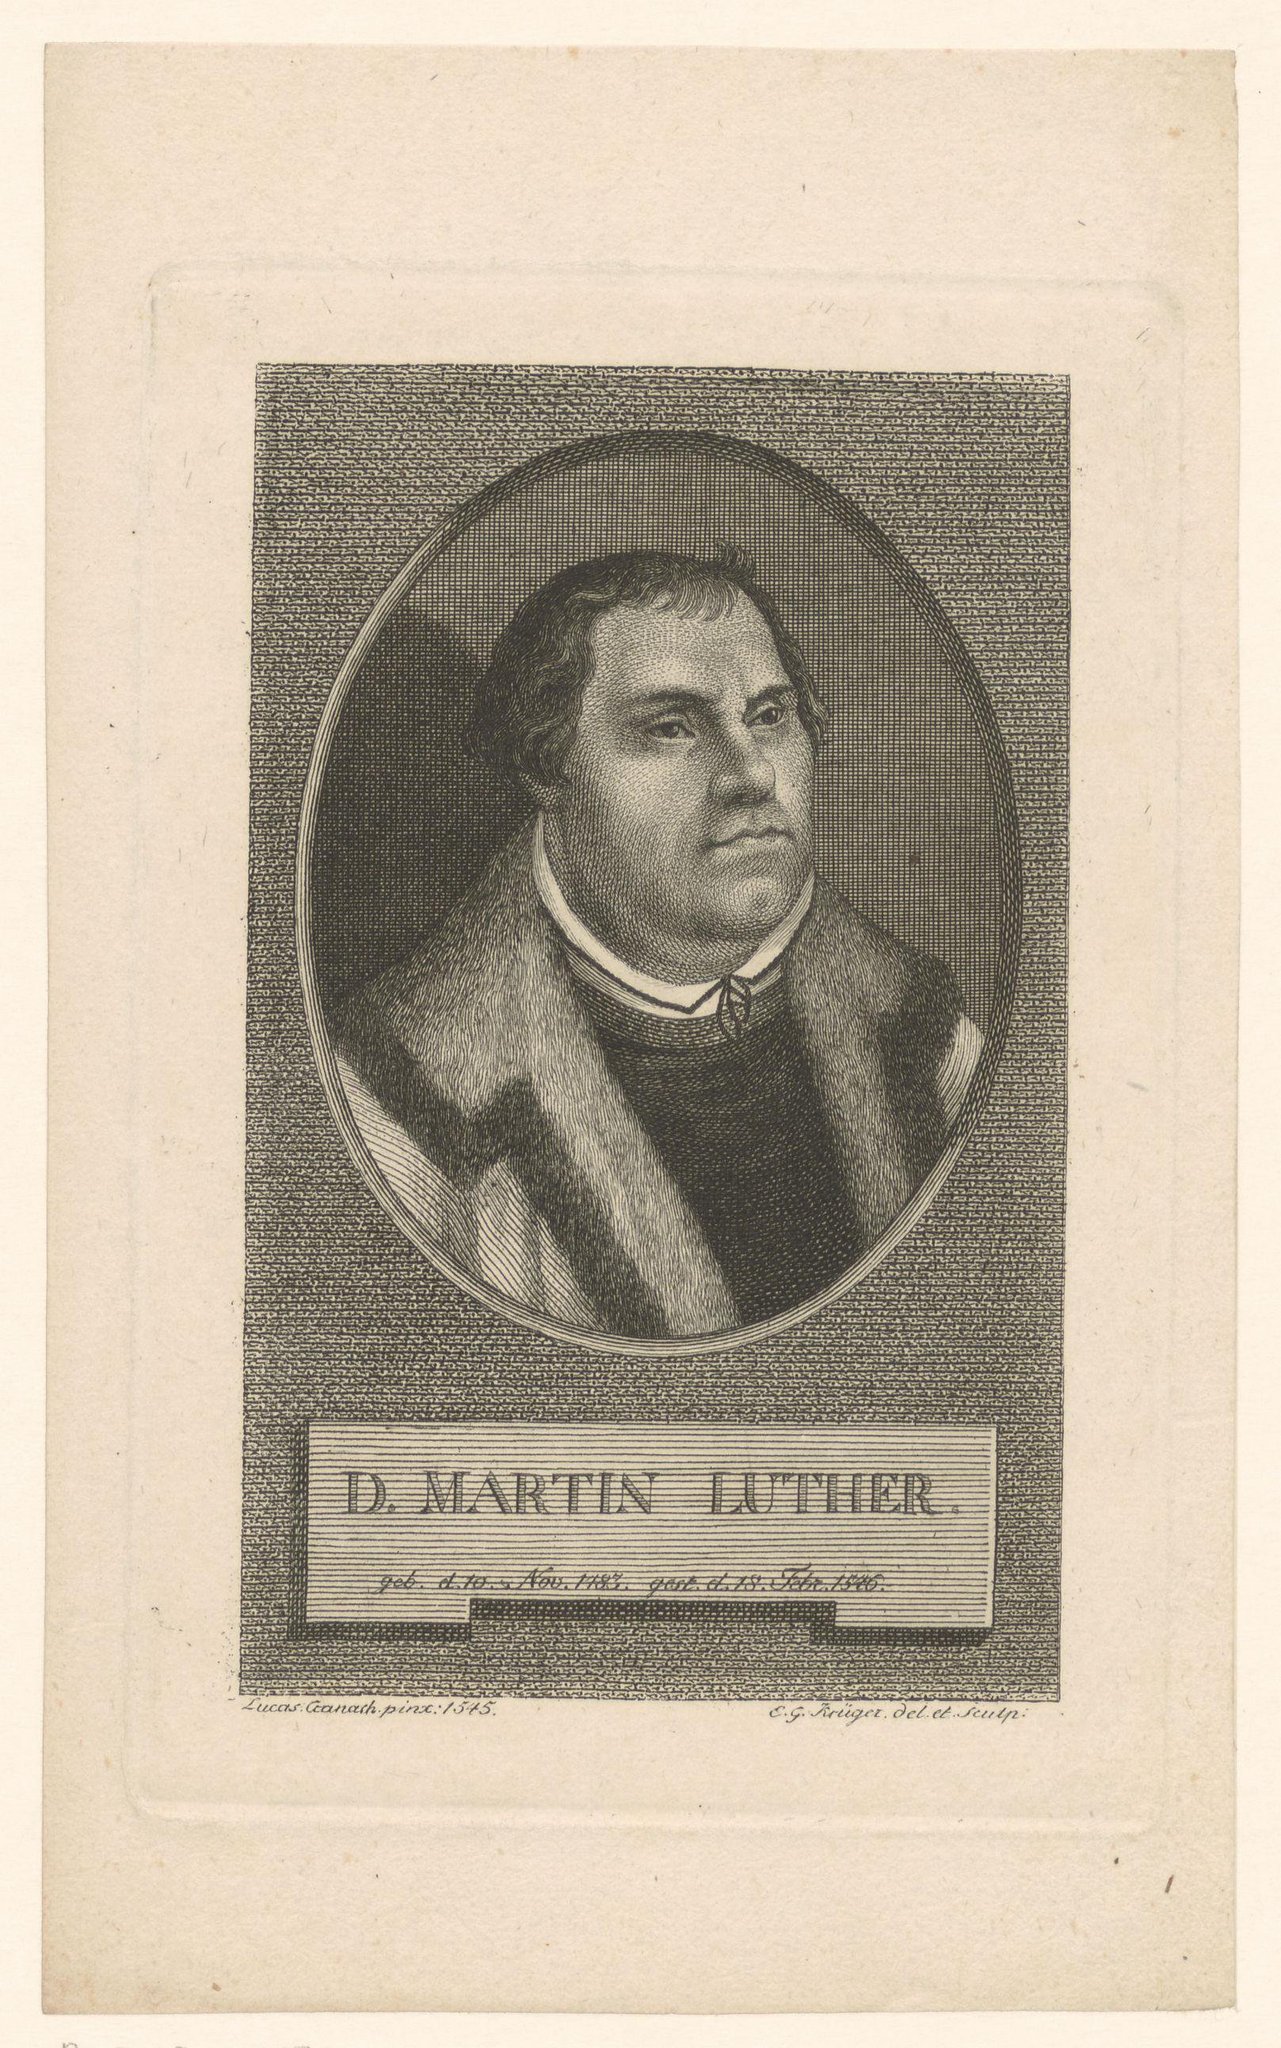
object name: print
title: Portret van Martin Luther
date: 1766-1834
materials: paper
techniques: engraving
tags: priest, martin luther, theologian, historical persons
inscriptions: collector's mark: Lugt 2228